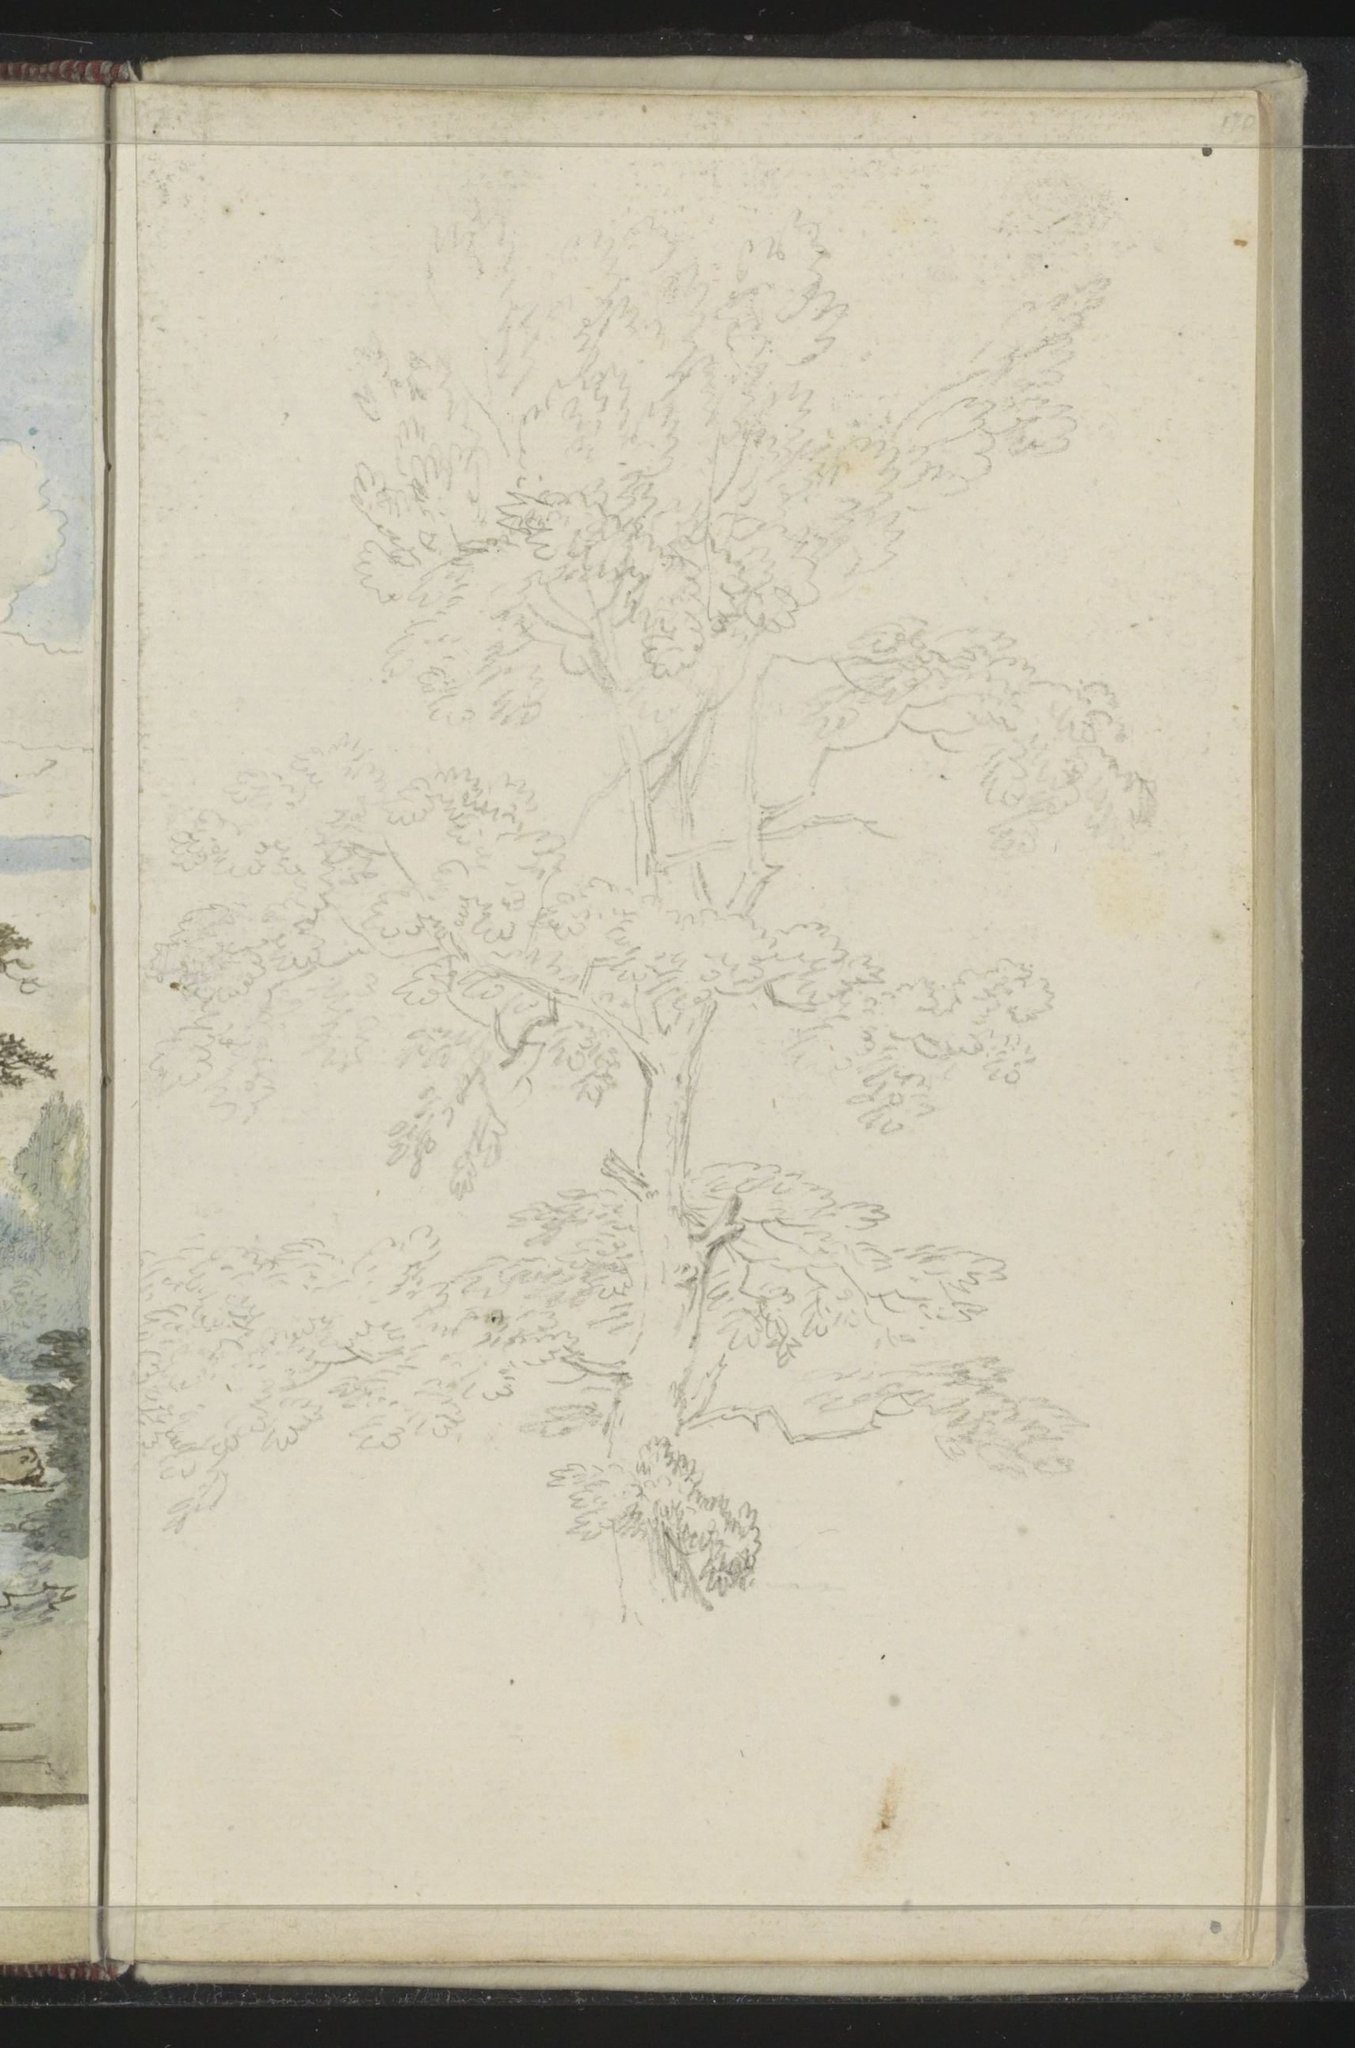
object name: sketchbook leaf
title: Boom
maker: johannes huibert prins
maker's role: draughtsman, painter, print maker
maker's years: 1757-1806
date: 1783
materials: paper, pencil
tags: trees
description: Pagina 170 uit een schetsboek met 175 pagina's.